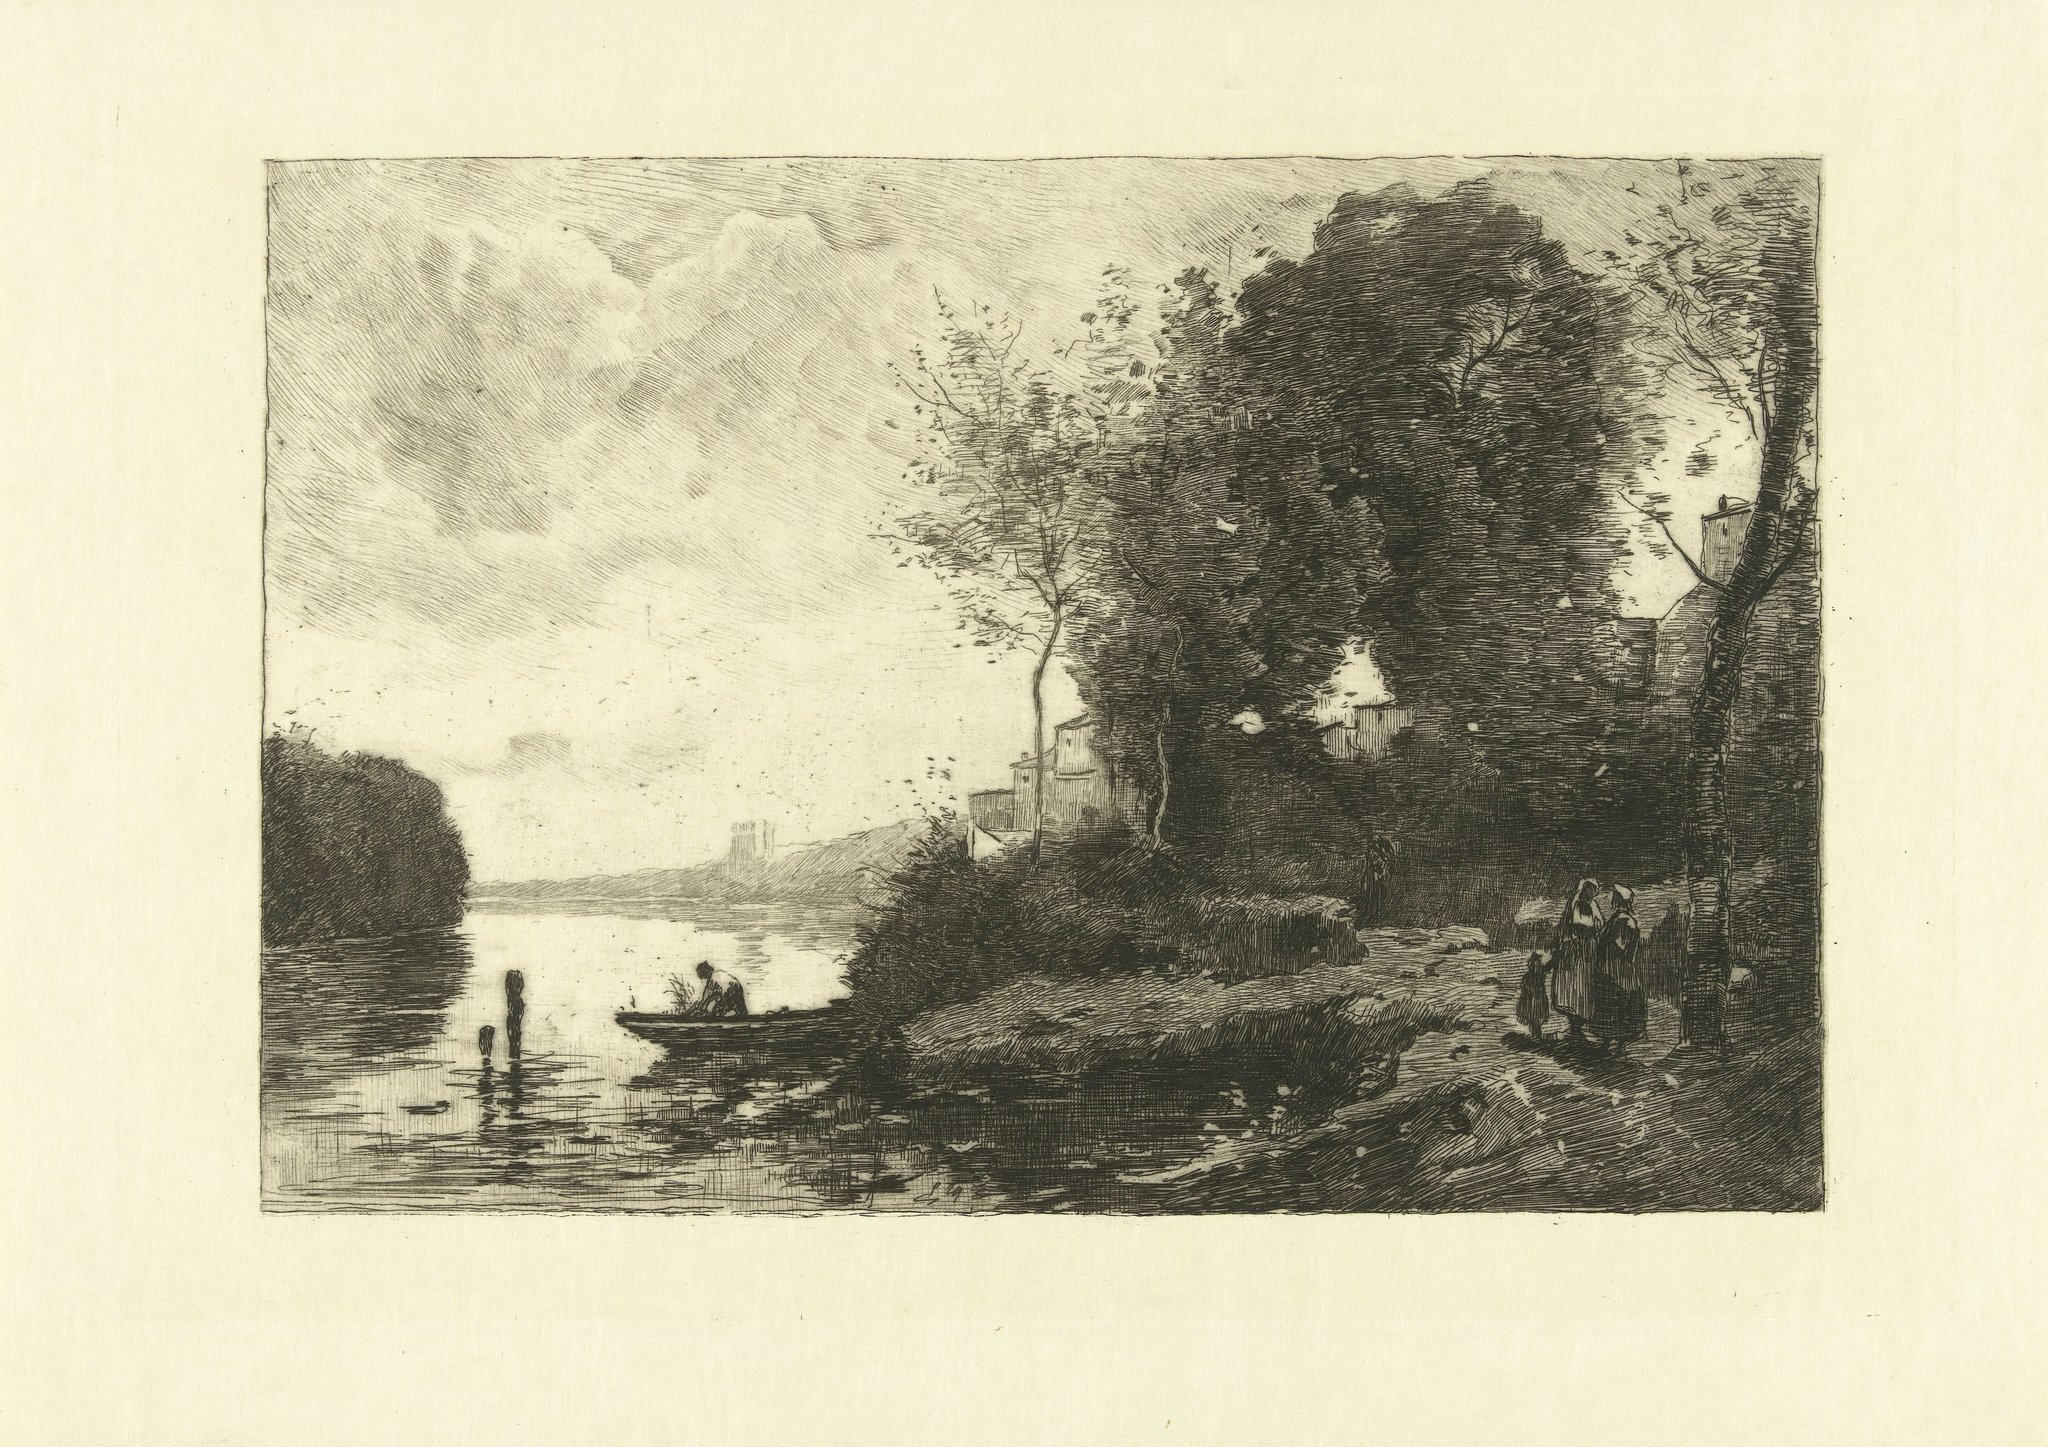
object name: print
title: Landschap met bomen en huizen aan rivier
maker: carel lodewijk dake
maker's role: draughtsman, painter, print maker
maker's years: 1857-1918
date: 1867-1918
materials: paper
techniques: drypoint, etching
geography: netherlands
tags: river, river bank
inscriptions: collector's mark: Lugt 2228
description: Prent naar schilderij van Camille Corot.